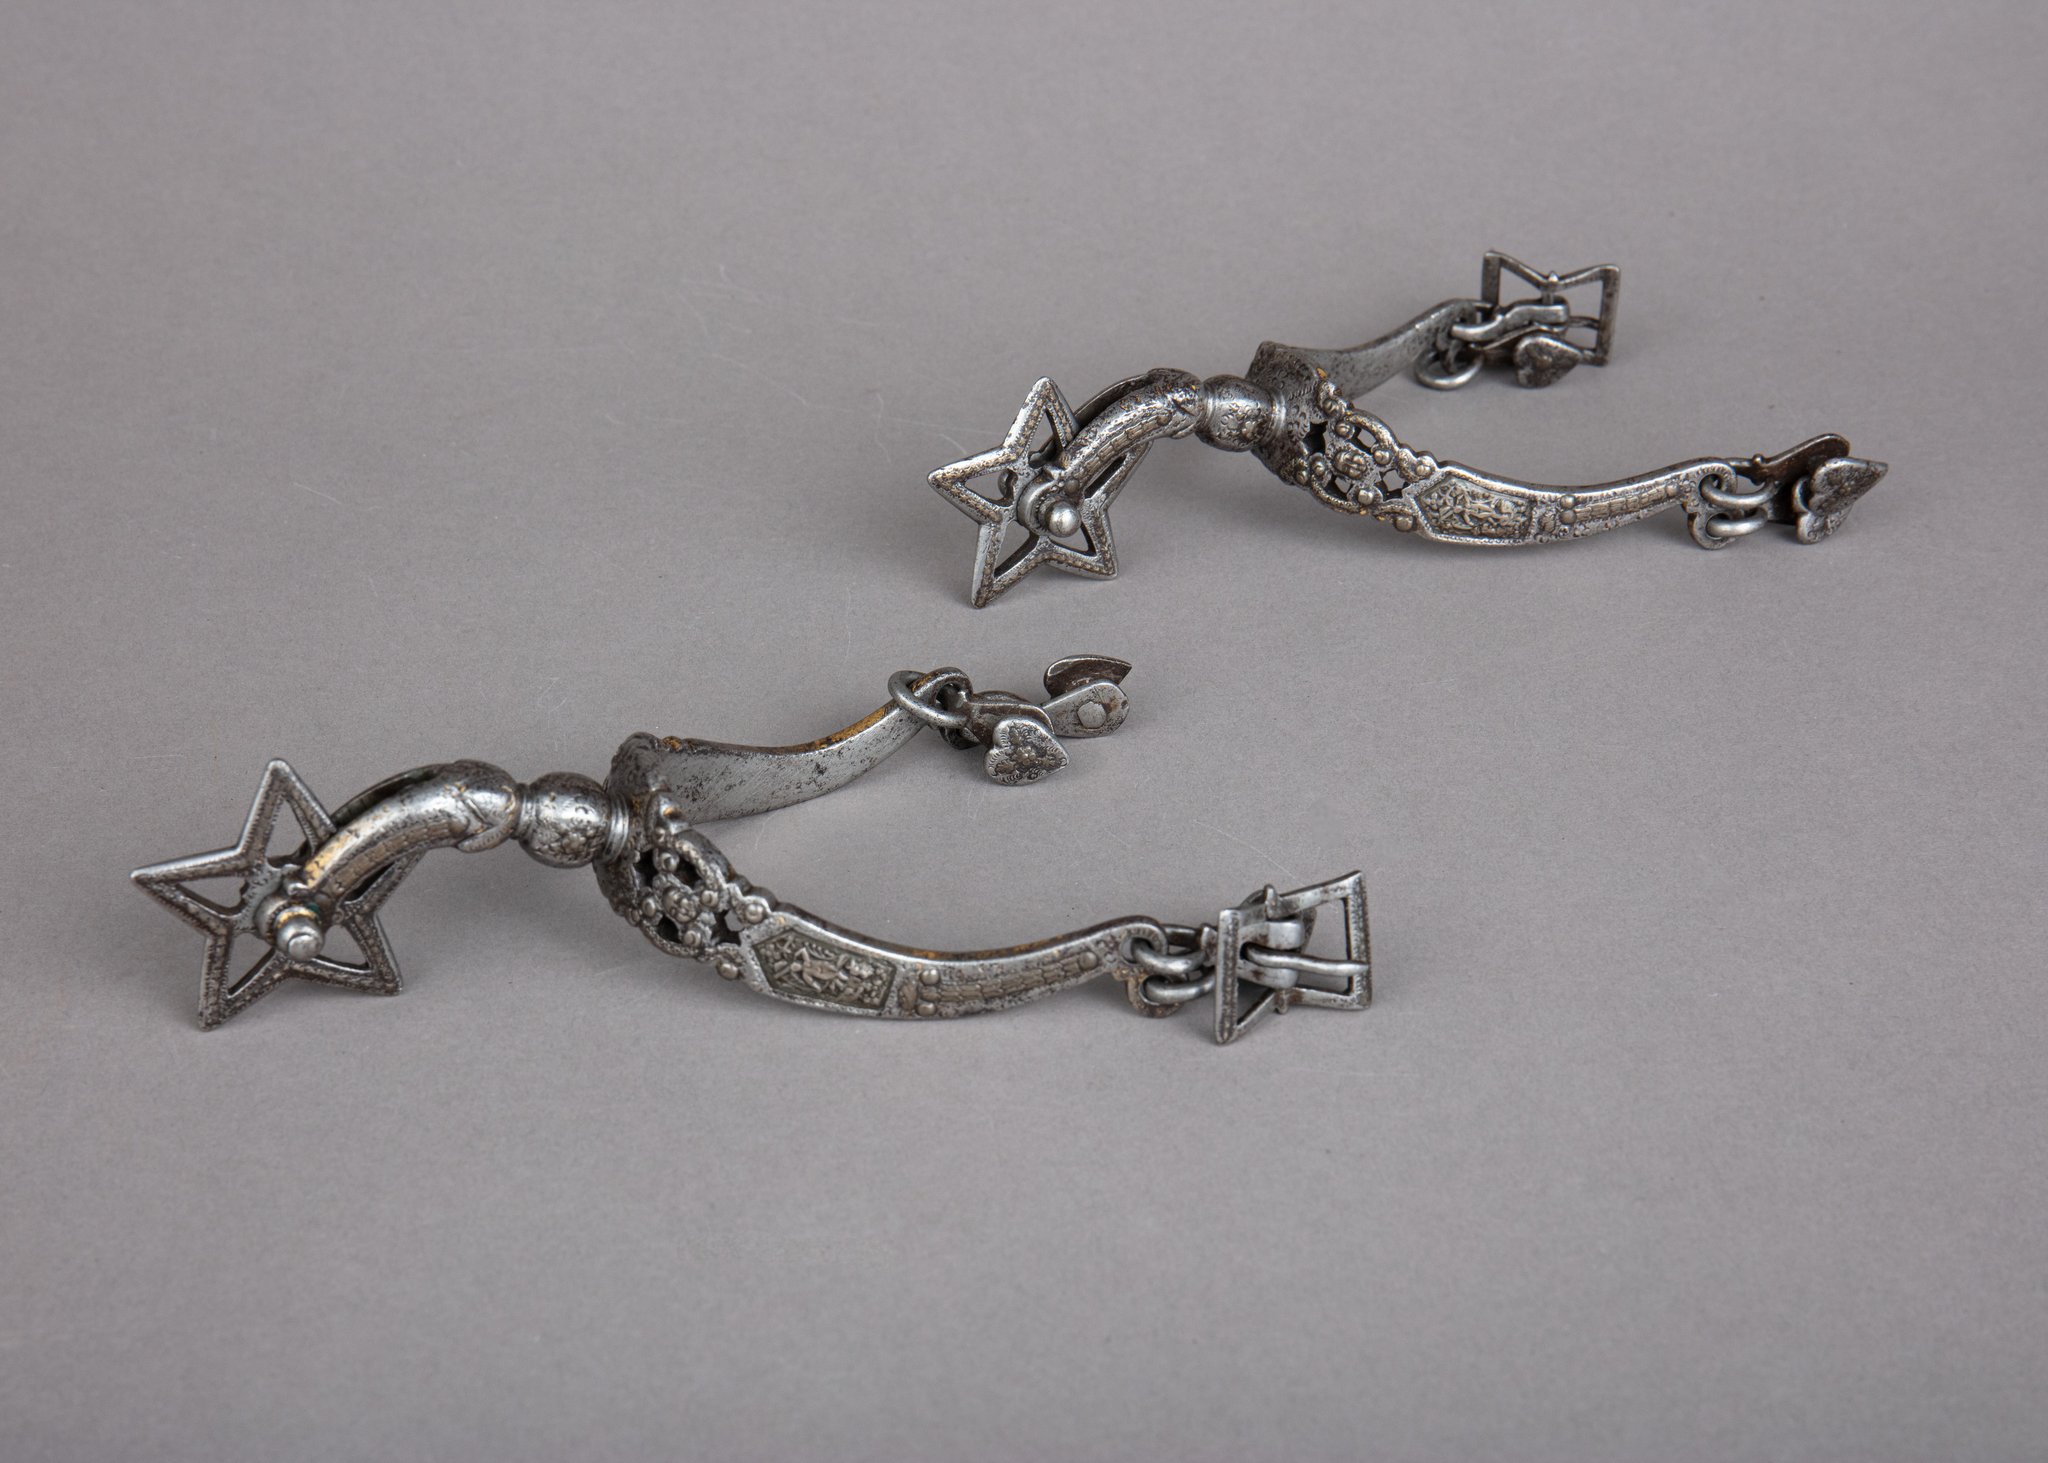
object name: spur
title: Pair of Rowel Spurs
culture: german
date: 1601-1700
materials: gold, metal alloy, silver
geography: germany